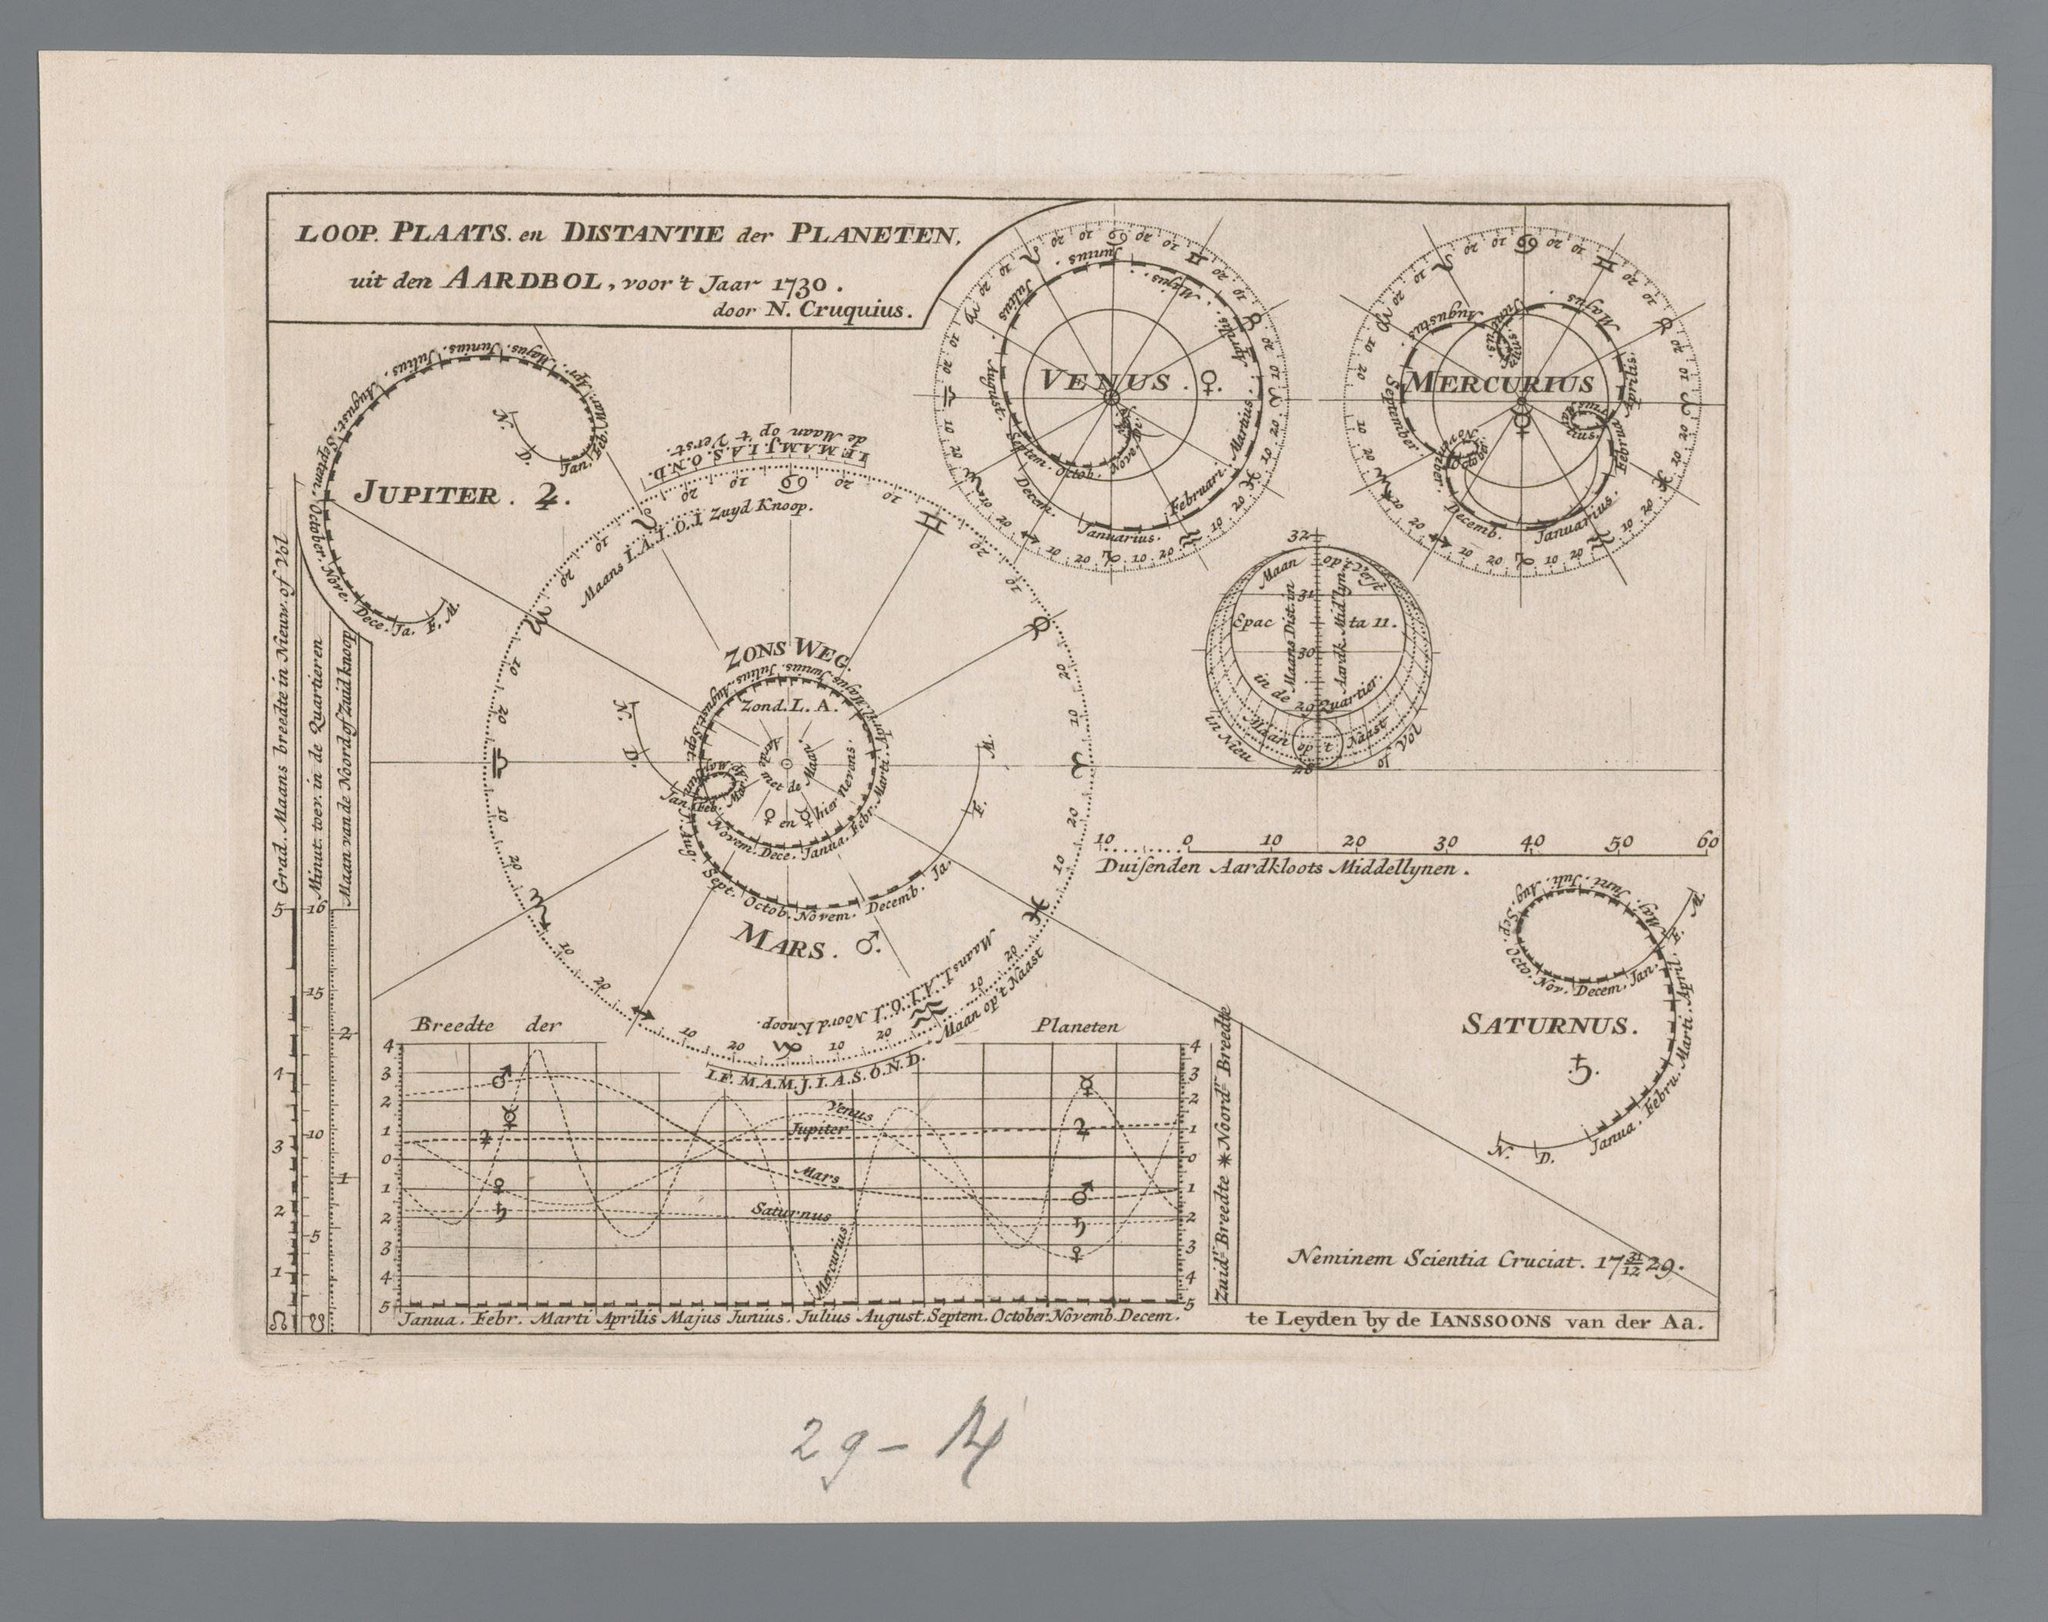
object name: print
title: Loop, plaats en distantie der planeten, uit den aardbol voor 't jaar 1730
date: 1729-1730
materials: paper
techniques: engraving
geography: leiden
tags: star-chart, star map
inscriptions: date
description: Kaart met de planetenbanen voor het jaar 1730. Onder een tabel met de stand van de planeten per maand. In het midden kaarten met de baan van de planeten.